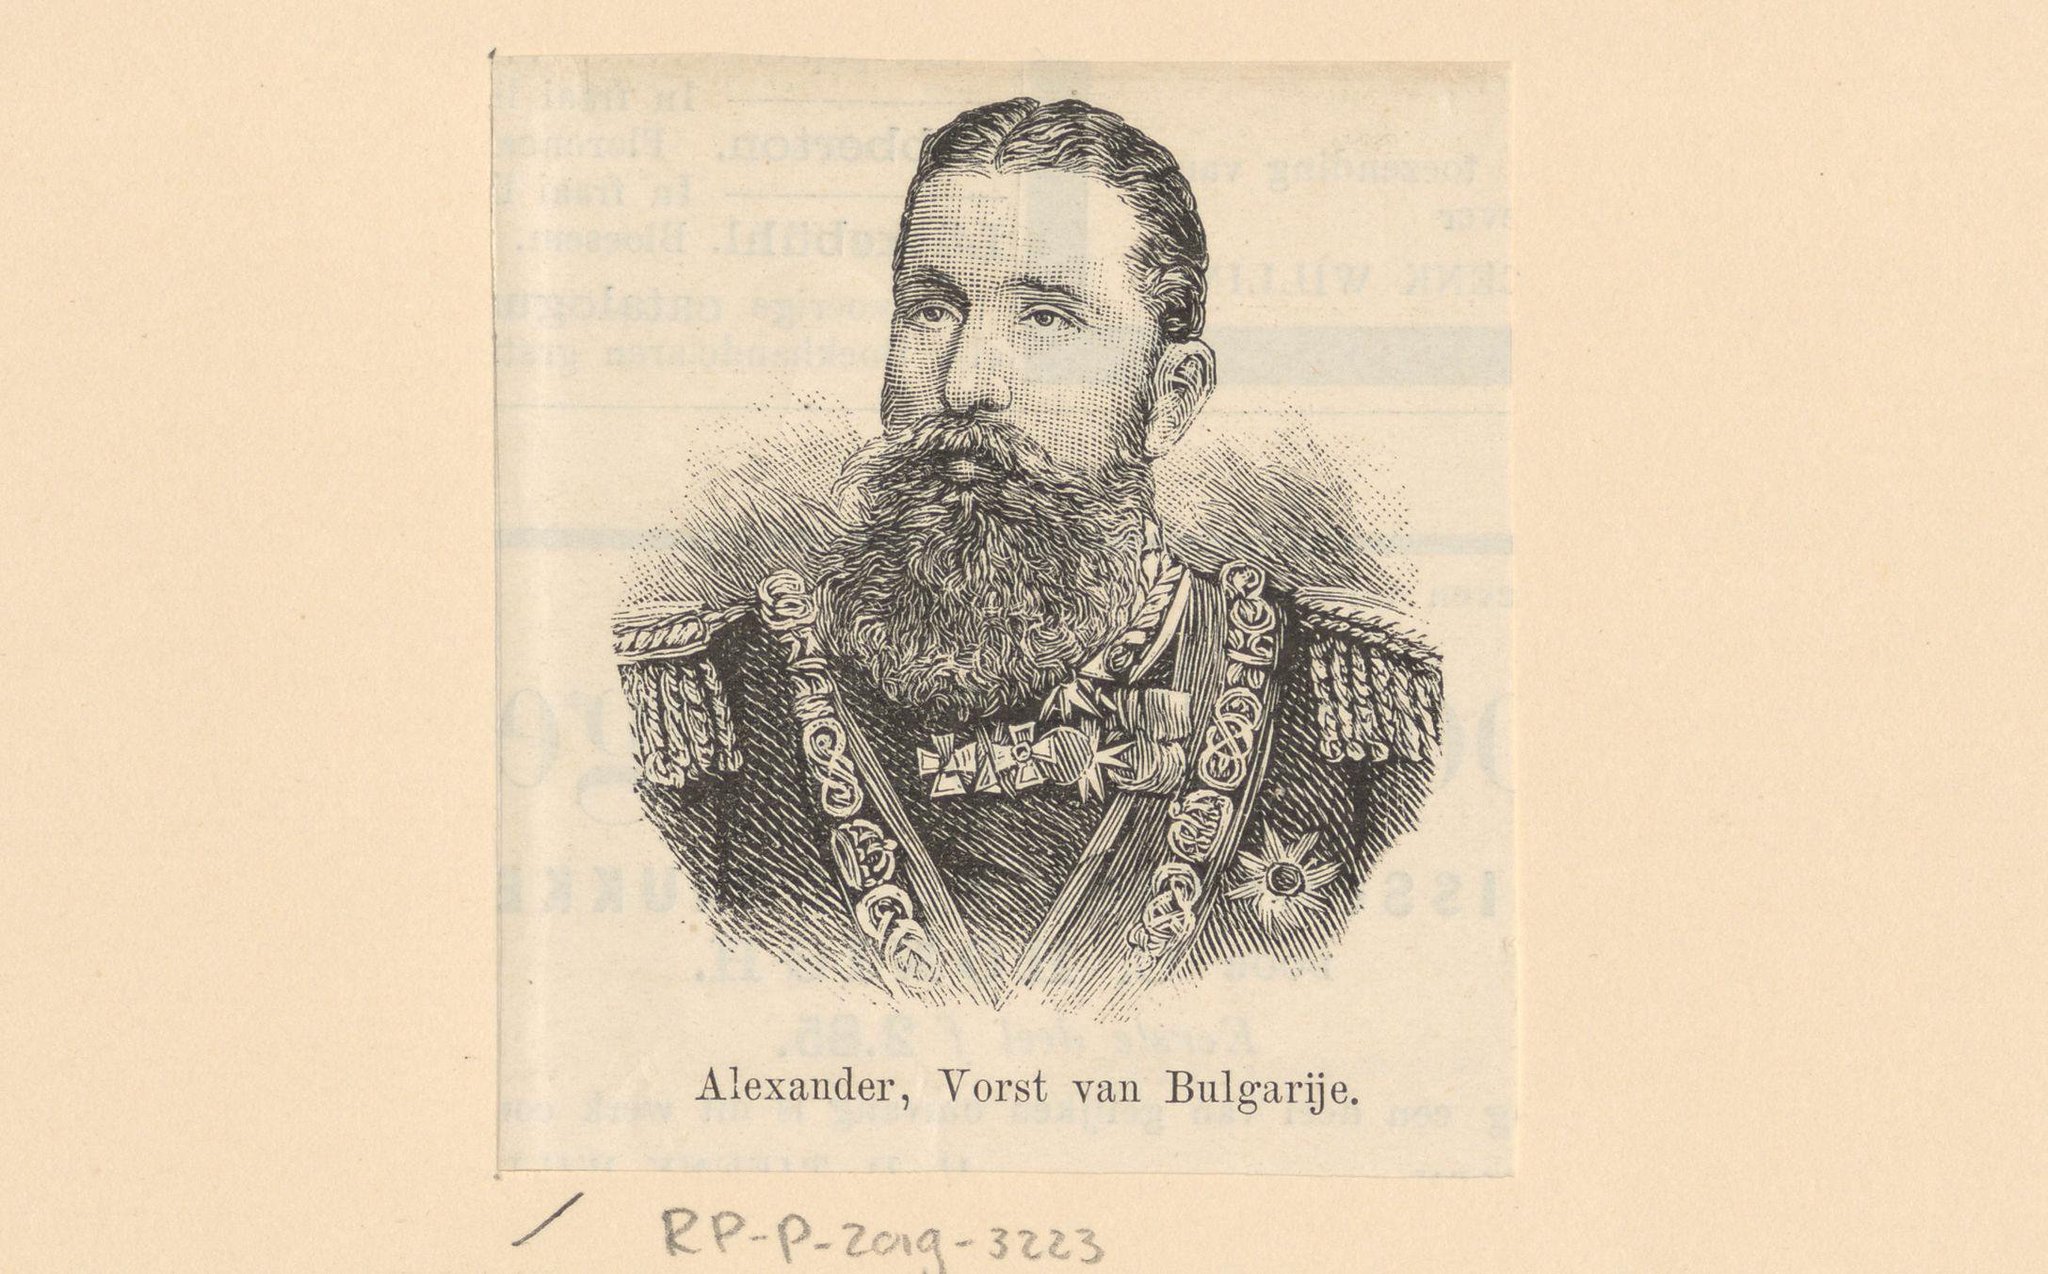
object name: print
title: Portret van Alexander I van Bulgarije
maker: Anonymous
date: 1879-1886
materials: paper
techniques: engraving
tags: historical persons